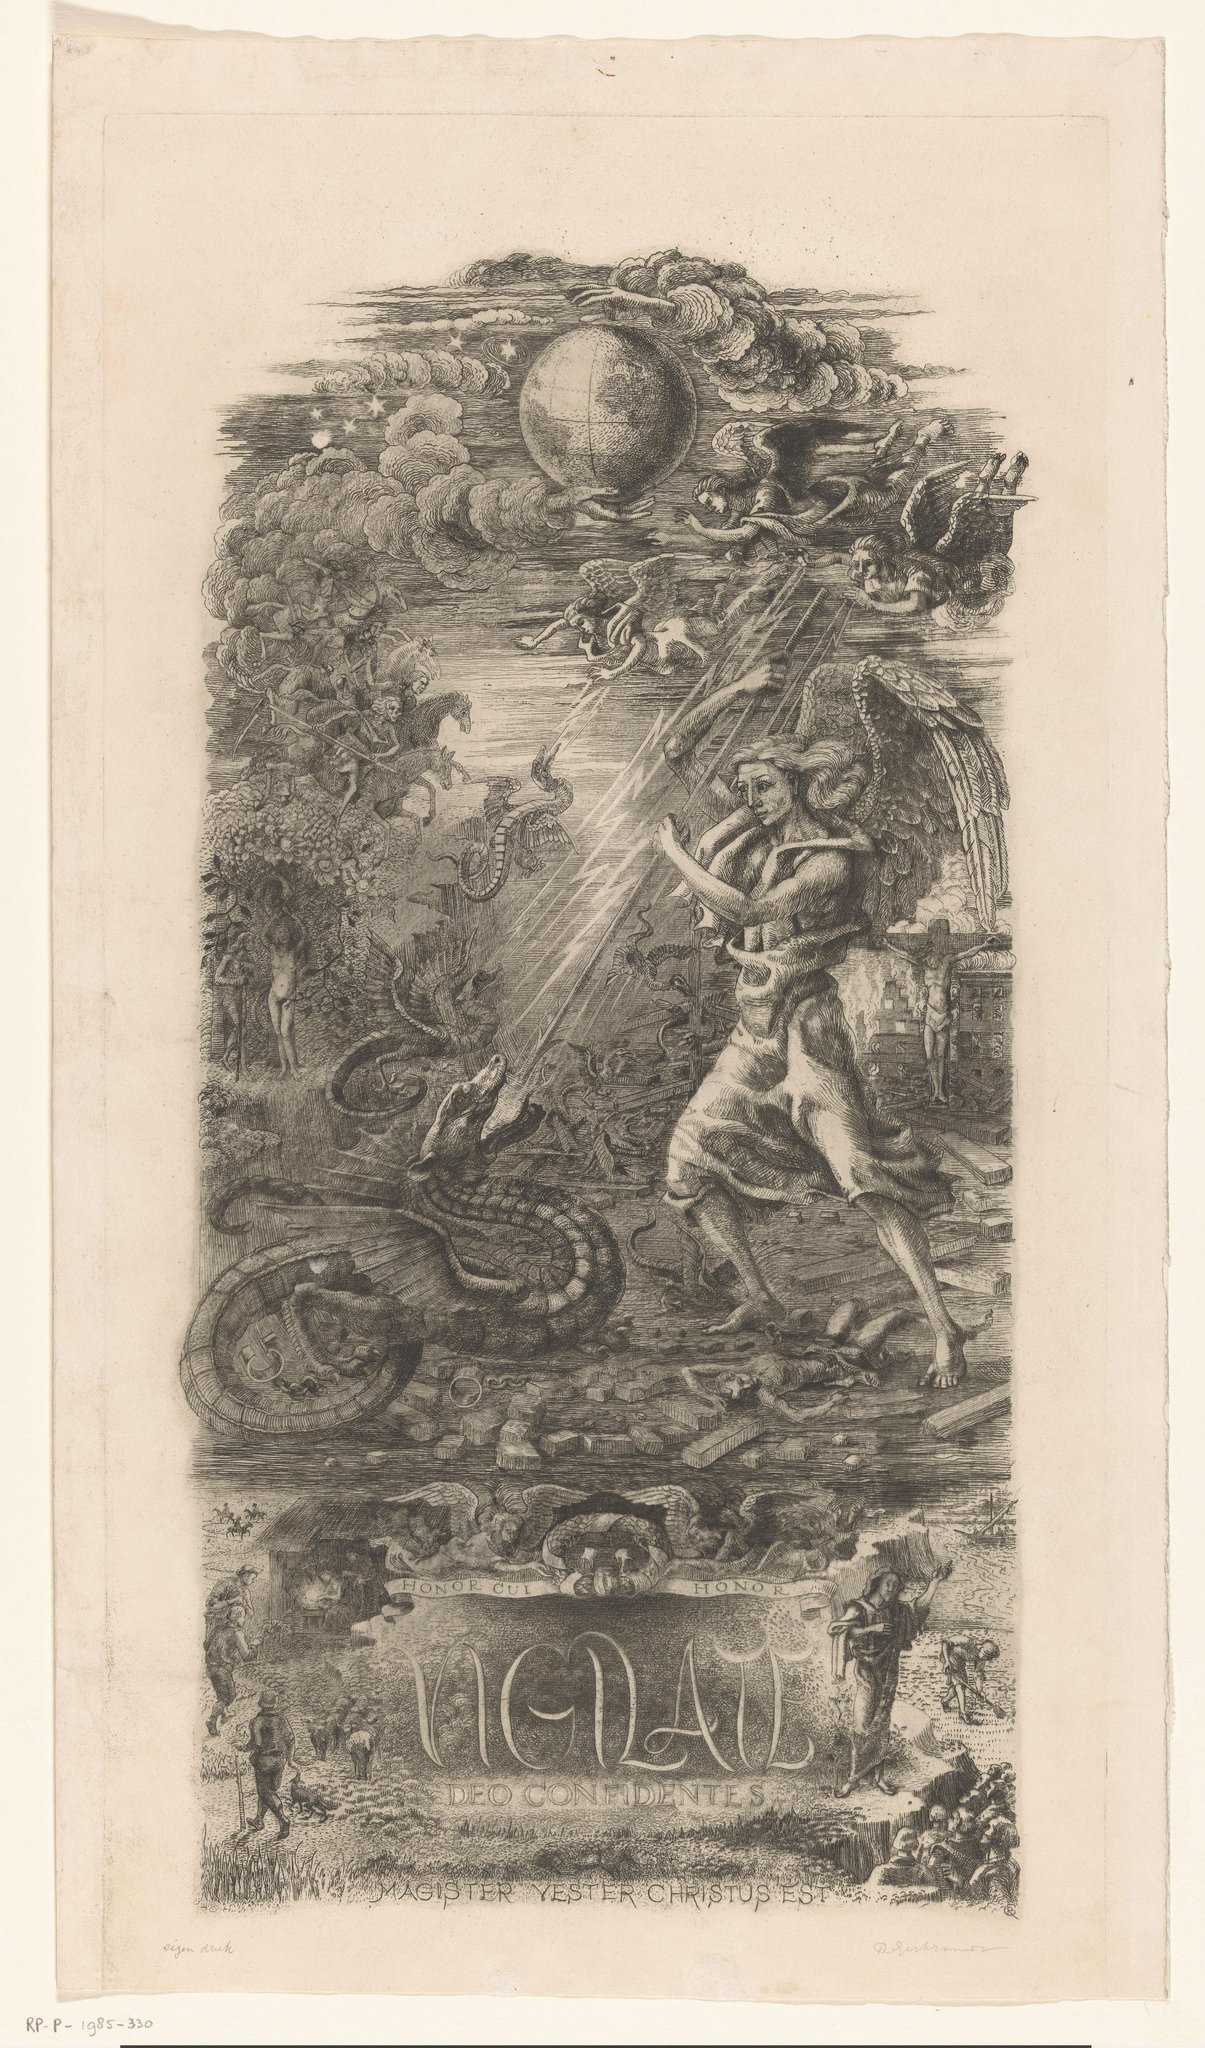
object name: print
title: Vigilate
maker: roelf gerbrands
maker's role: designer, draughtsman, print maker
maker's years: 1891-1954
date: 1948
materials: paper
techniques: etching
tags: the archangel michael fighting the dragon (devil, satan), the four horsemen of the apocalypse, eve takes the fruit from the serpent (or the tree) in the presence of adam (who may be trying to stop her), series of scenes from the life of christ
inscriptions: collector's mark: Lugt 2228, date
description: De aartsengel Michaël gaat Satan, in de gedaante van een draak, met een speer te lijf. Rechtsboven drie vliegende engelen die andere draken aanvallen. Rechts Christus aan het kruis. Linksboven de vier ruiters van de Apocalyps, daaronder Adam, Eva en de slang bij de boom van de kennis van goed en kwaad. Linksonder de aanbidding van het Christuskind door de drie herders.